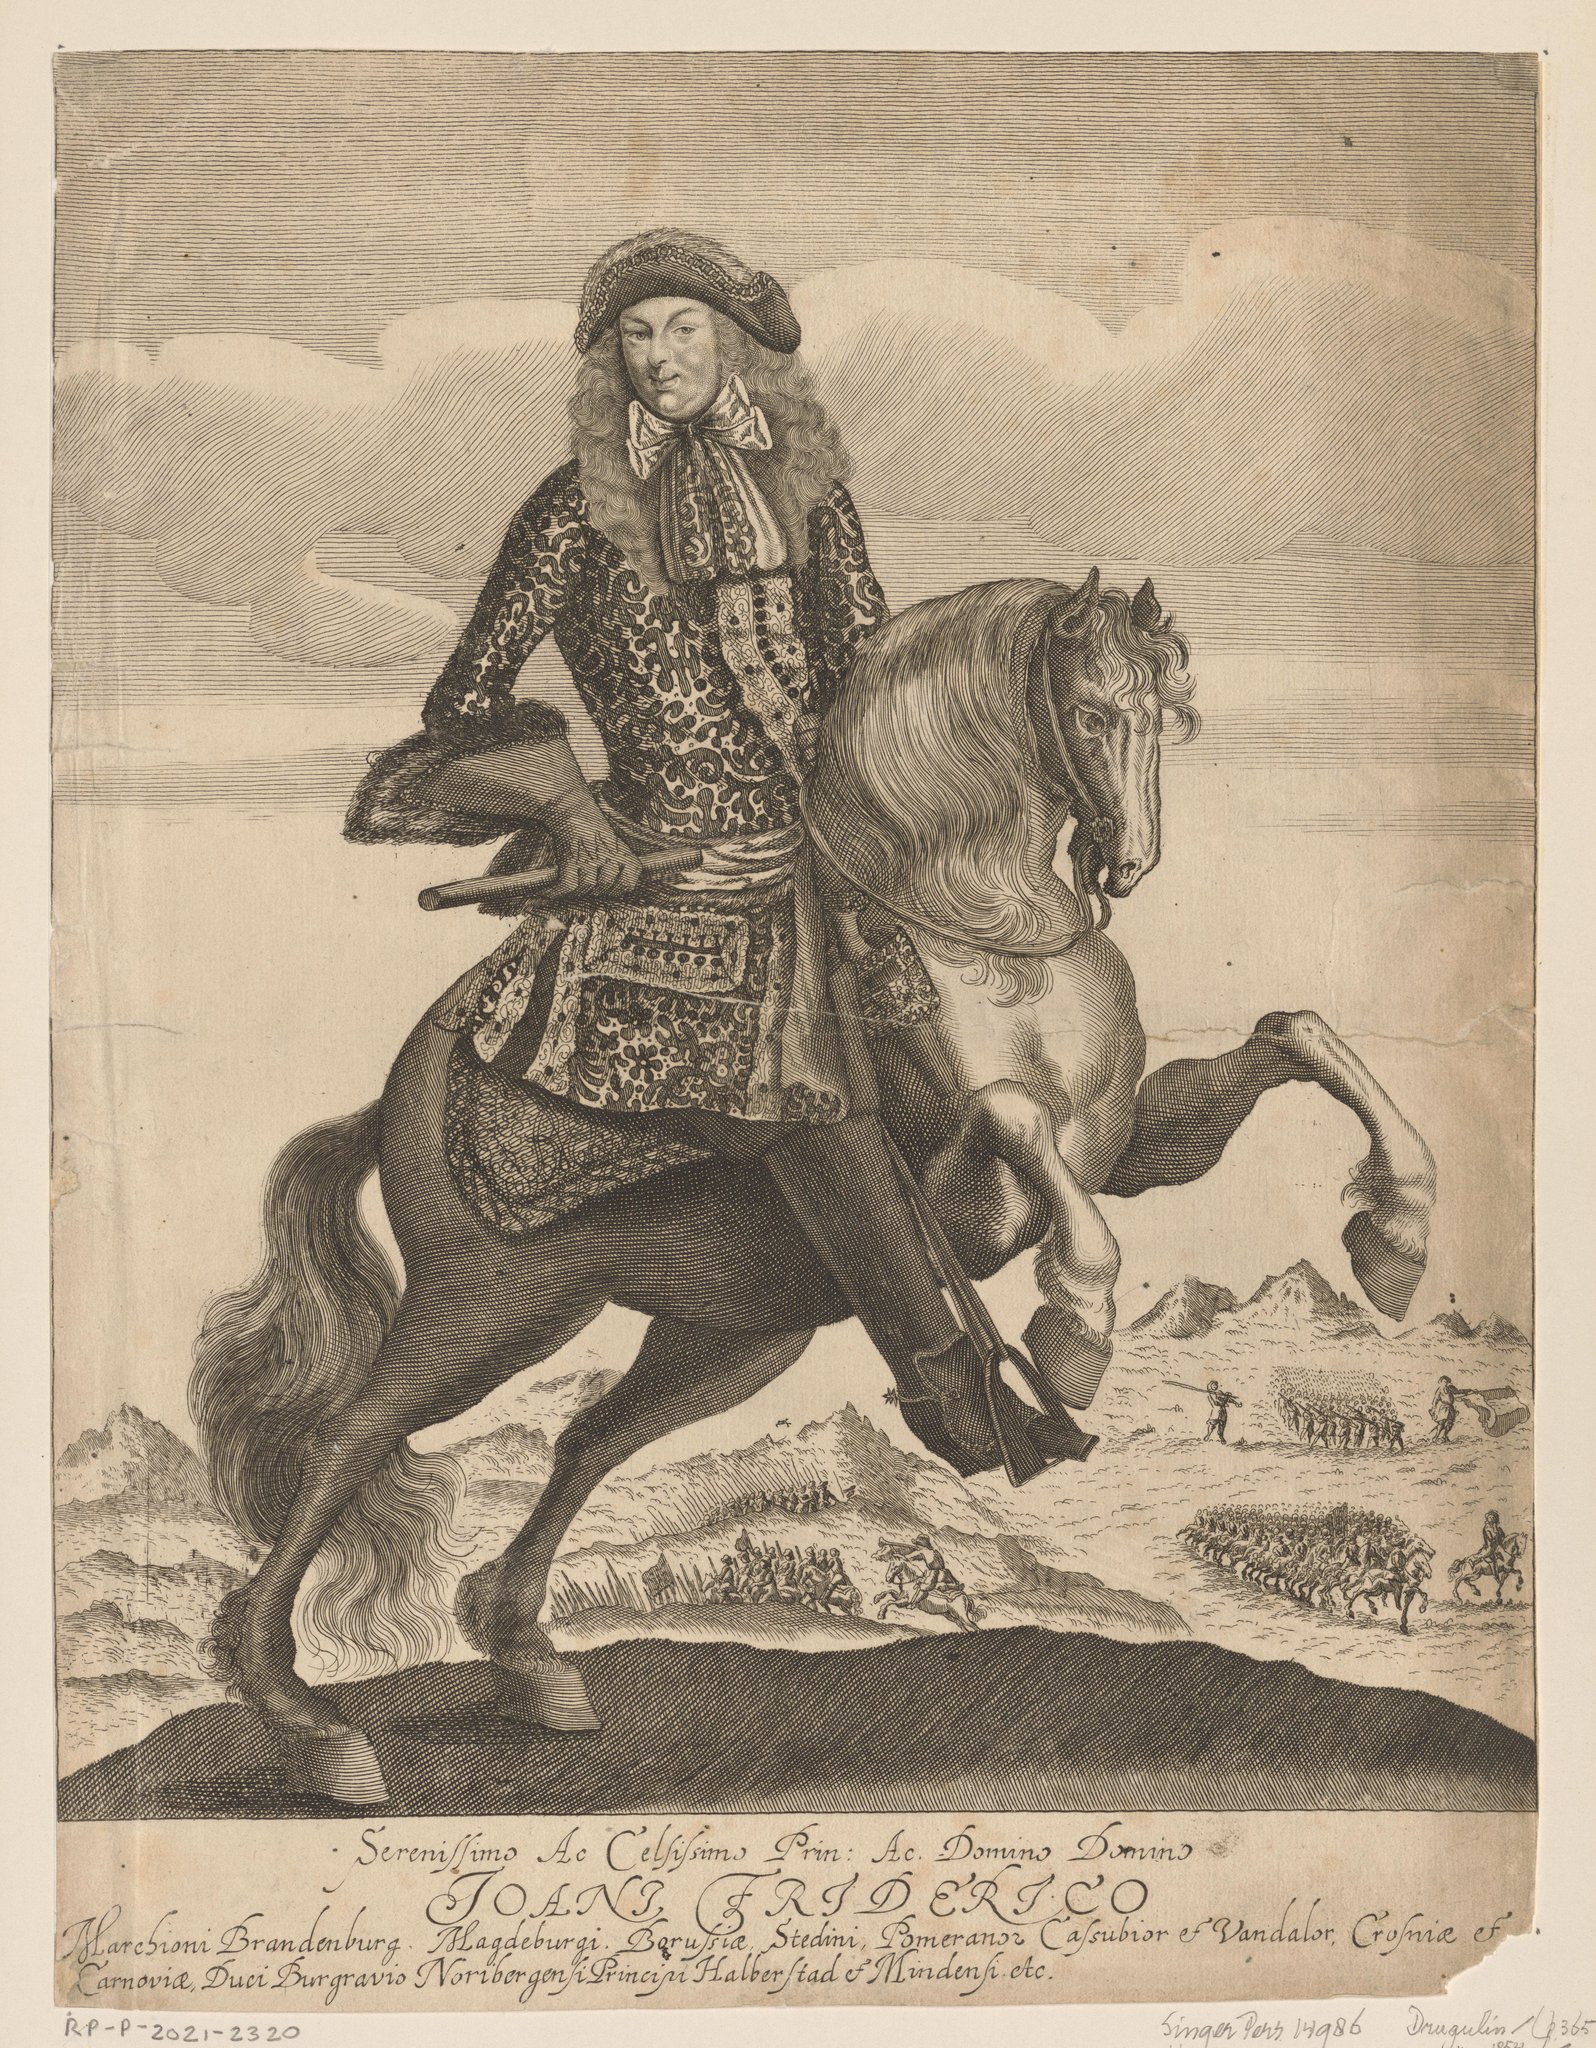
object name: print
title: Ruiterportret van Johan Frederik van Brandenburg-Ansbach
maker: Anonymous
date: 1672-1699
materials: paper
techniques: engraving, etching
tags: equestrian state-portrait, historical persons